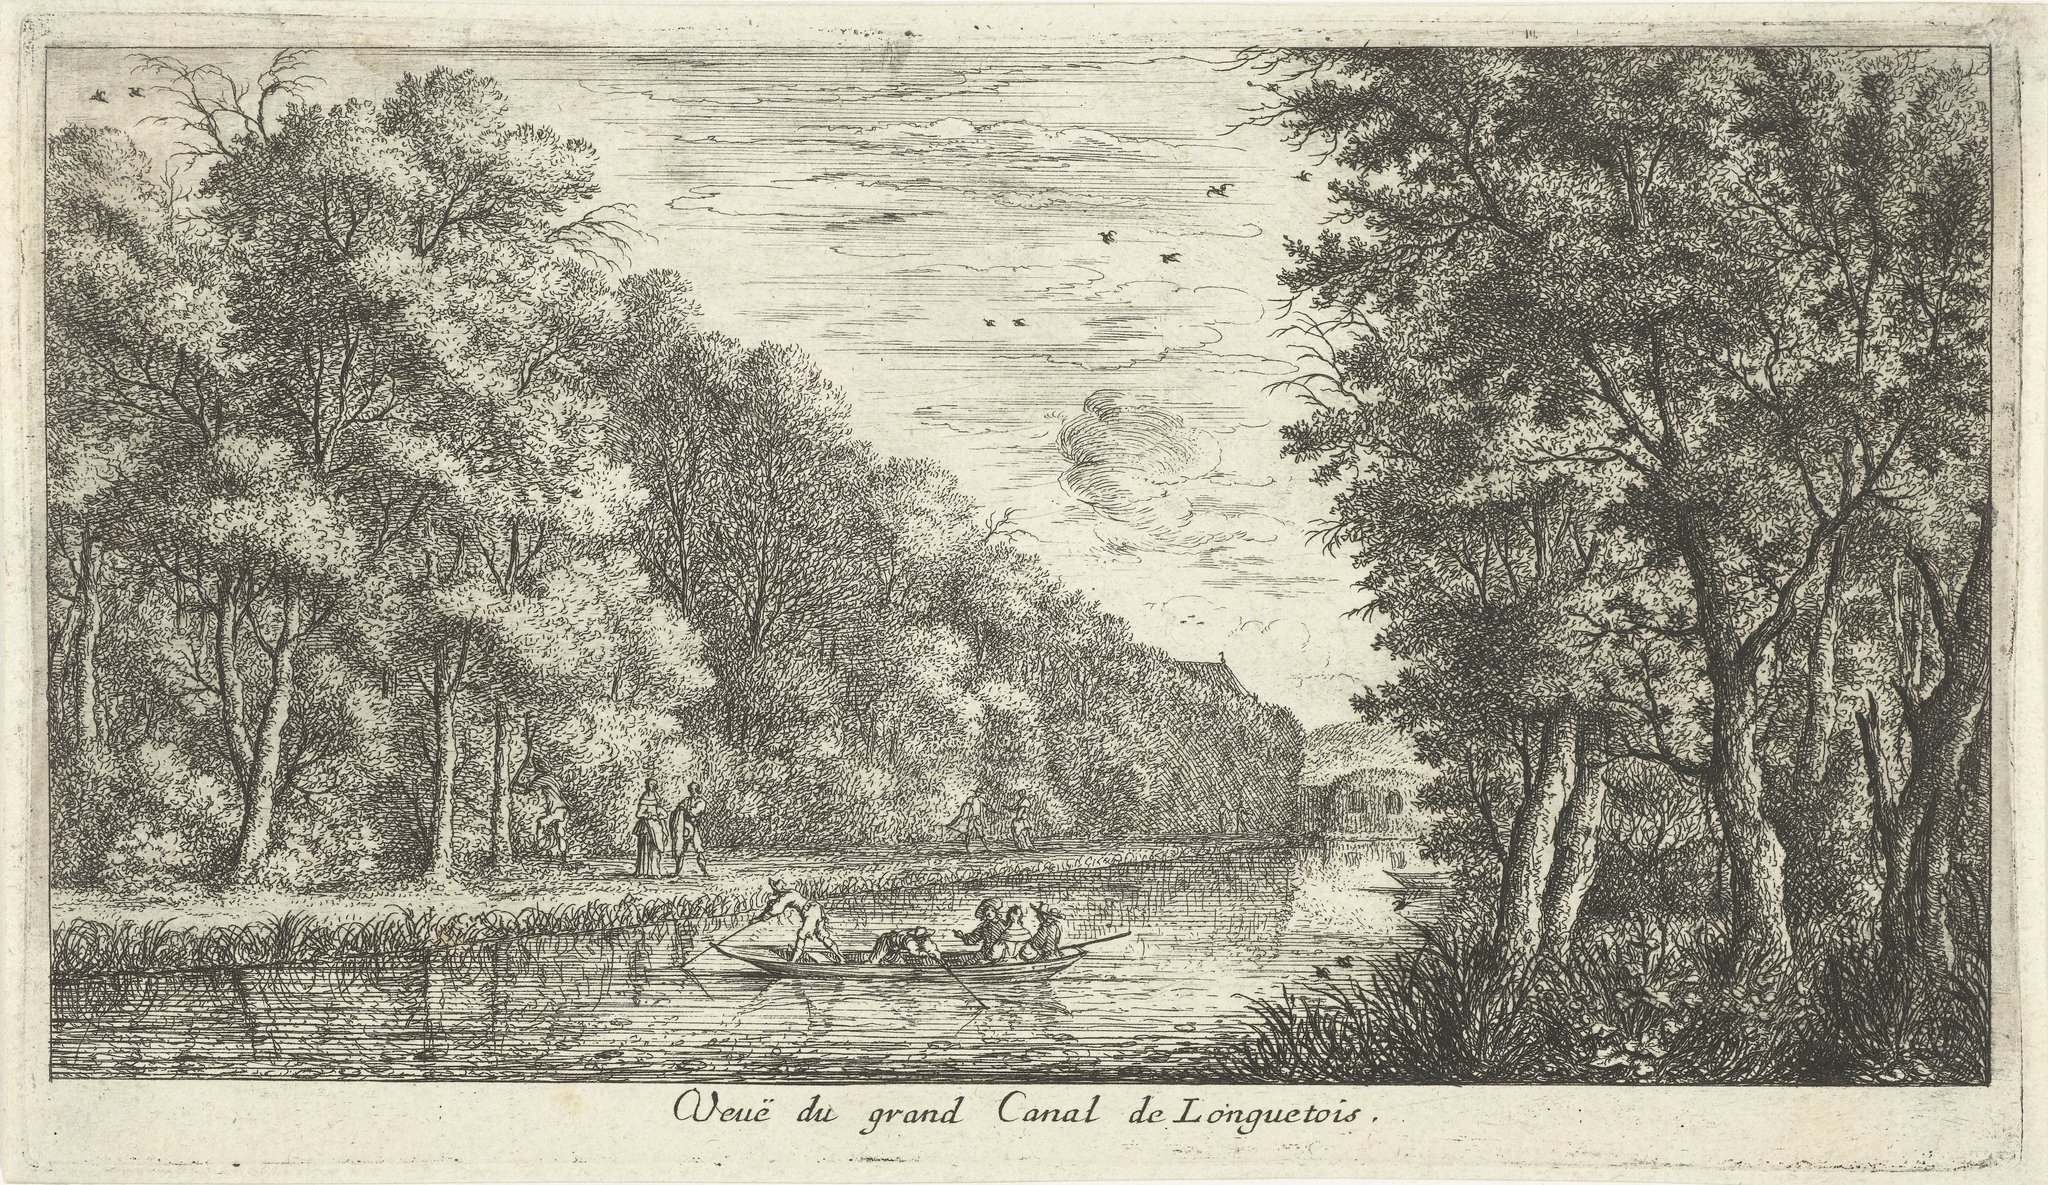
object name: print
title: Gezichten op kasteel Longuetoise en omgeving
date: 1648-1672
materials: paper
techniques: etching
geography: paris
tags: canal (+ landscape with figures, staffage)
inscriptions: collector's mark: Lugt 2228, collector's mark: Lugt 2161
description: Gezicht op een kanaal met een roeiboot. Op de oever hoge bomen en wandelaars.